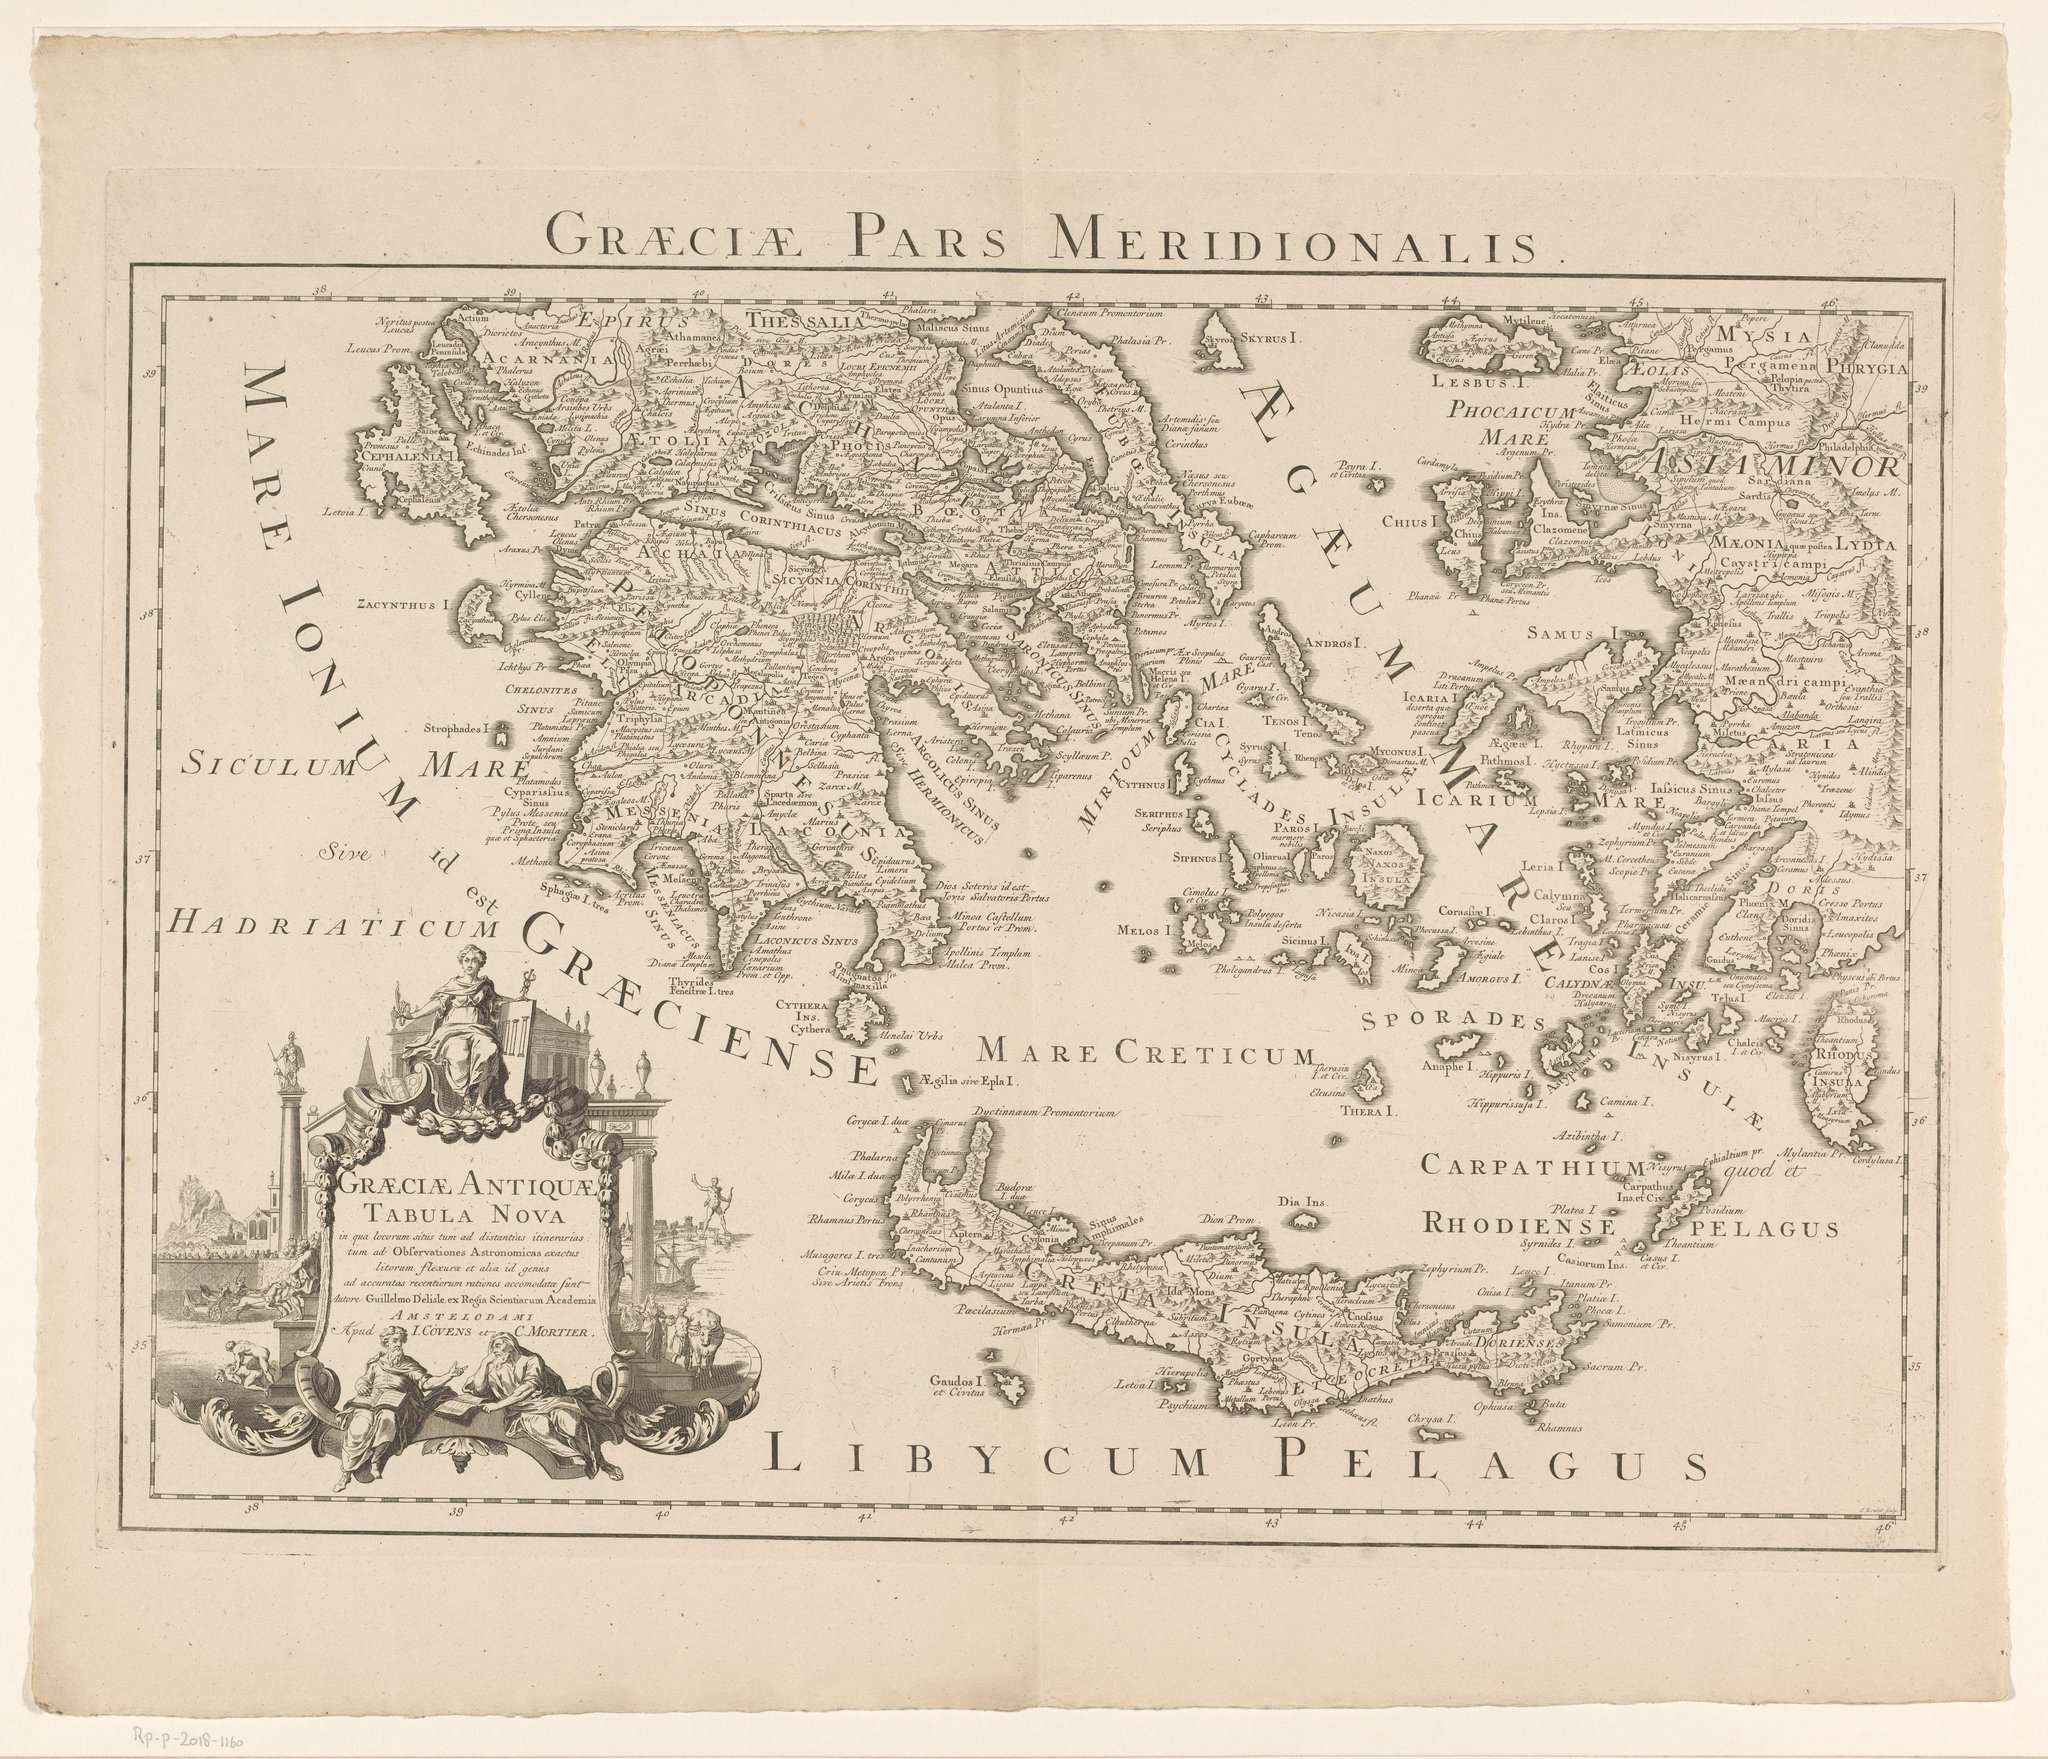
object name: map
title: Graeciae pars meridionalis / Graeciae antiquae tabula nova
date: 1721-1774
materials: paper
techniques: engraving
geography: amsterdam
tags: maps of separate countries or regions, column, pillar ~ architecture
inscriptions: collector's mark: Lugt 2228, collector's mark: Lugt 1641a